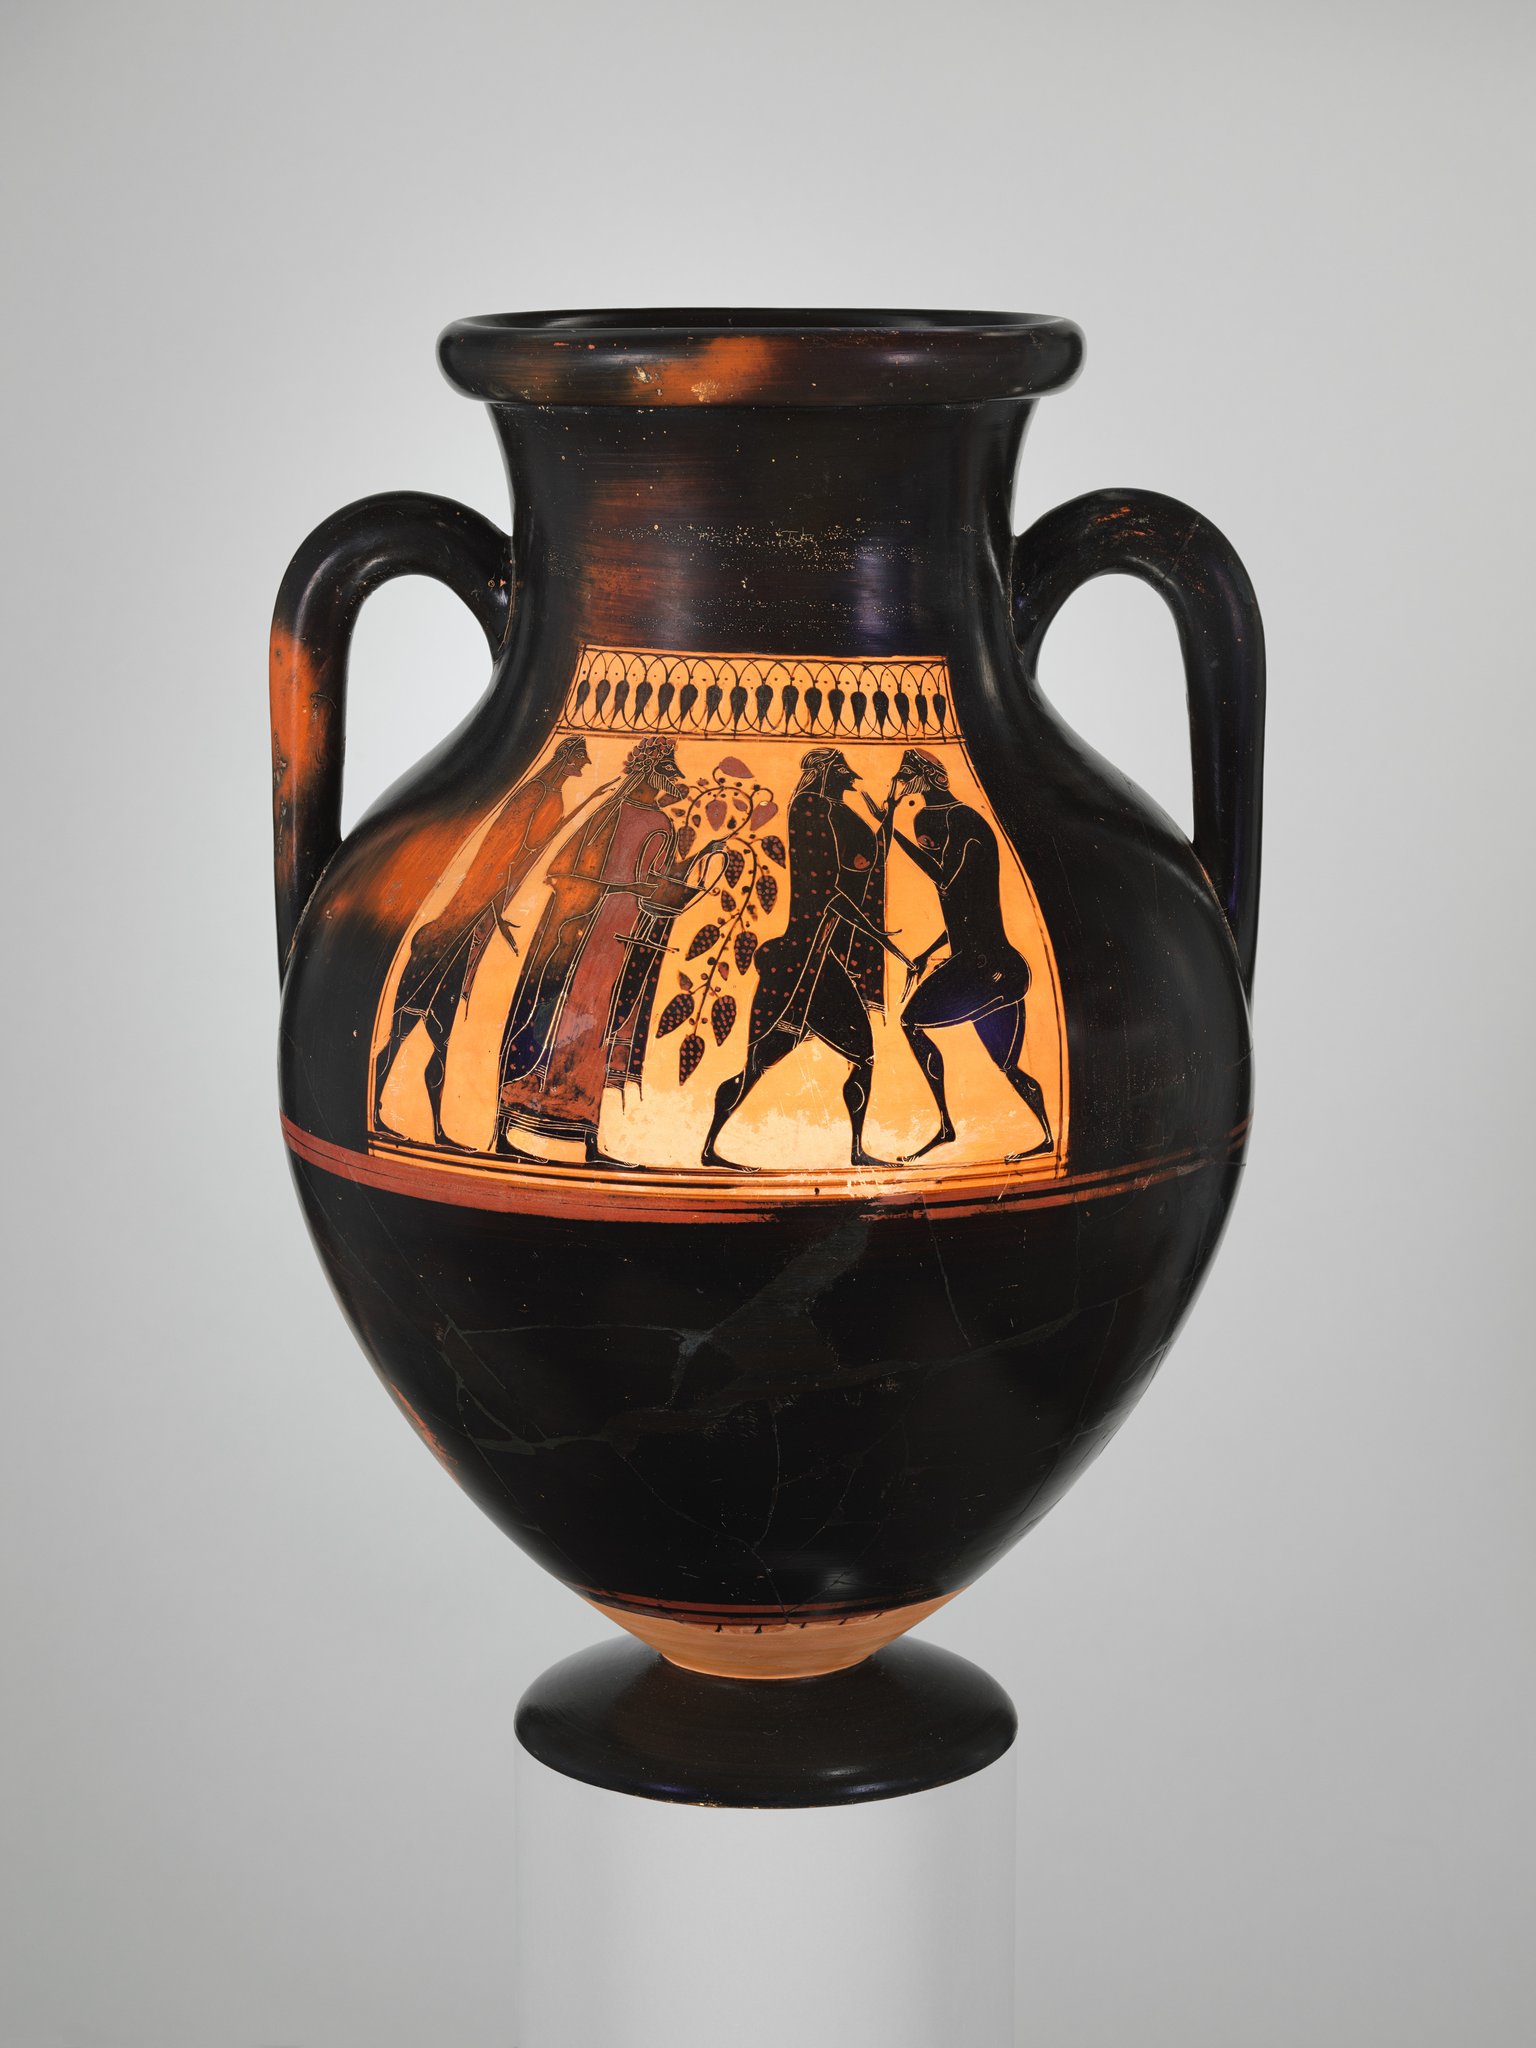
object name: amphora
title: Terracotta amphora (jar)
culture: greek, attic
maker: affecter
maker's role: artist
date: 550-530 BCE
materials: terracotta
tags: men,dionysus